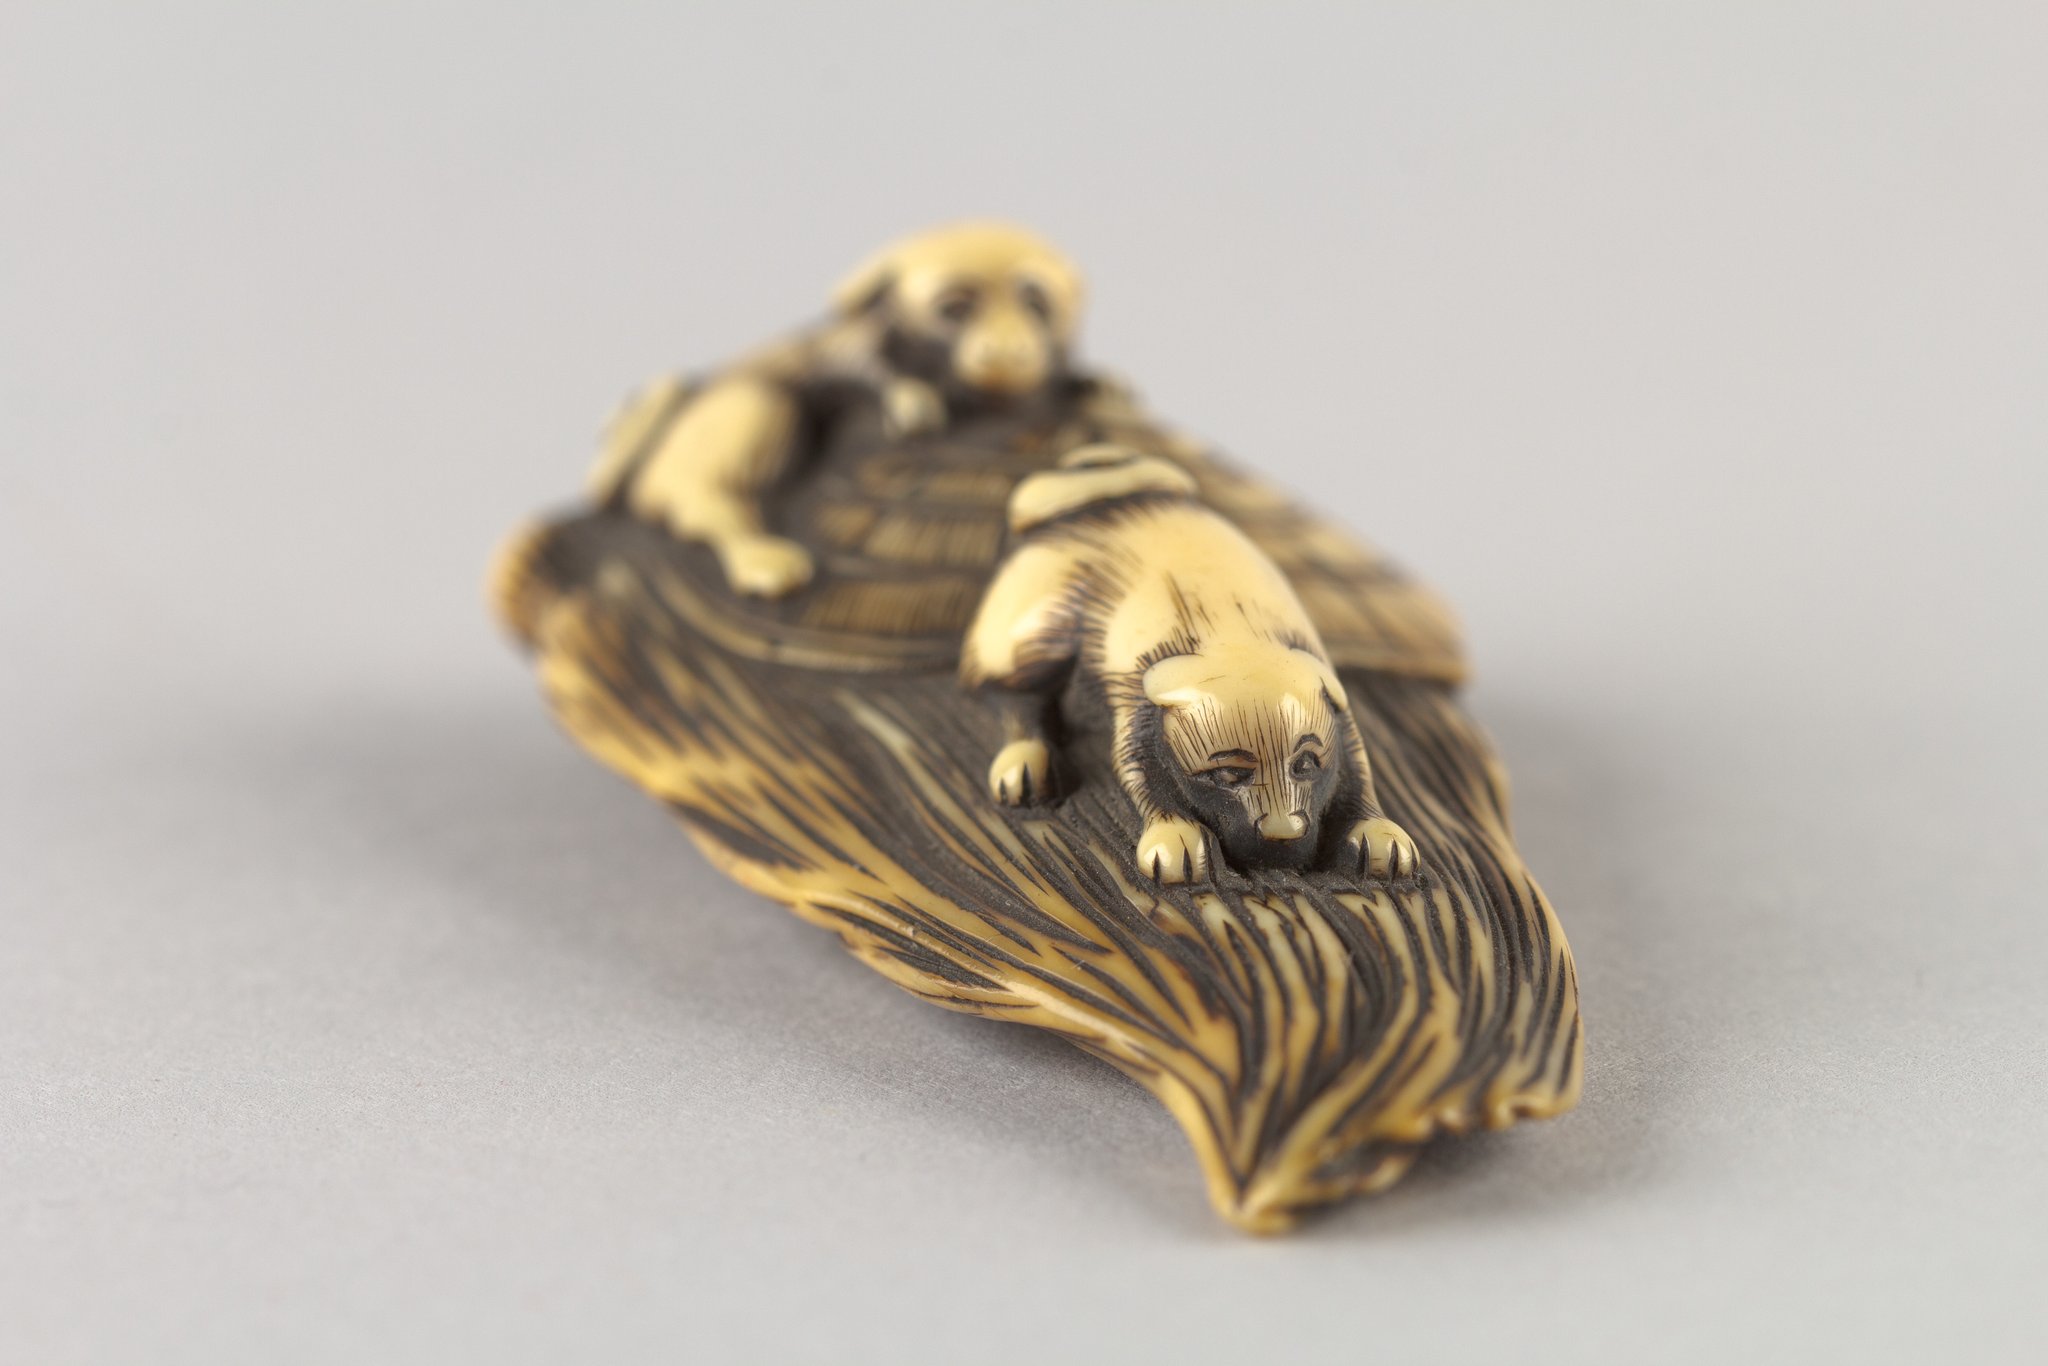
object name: netsuke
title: Netsuke of Puppies on a Bamboo Whisk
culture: japanese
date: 1701-1800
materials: ivory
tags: dogs